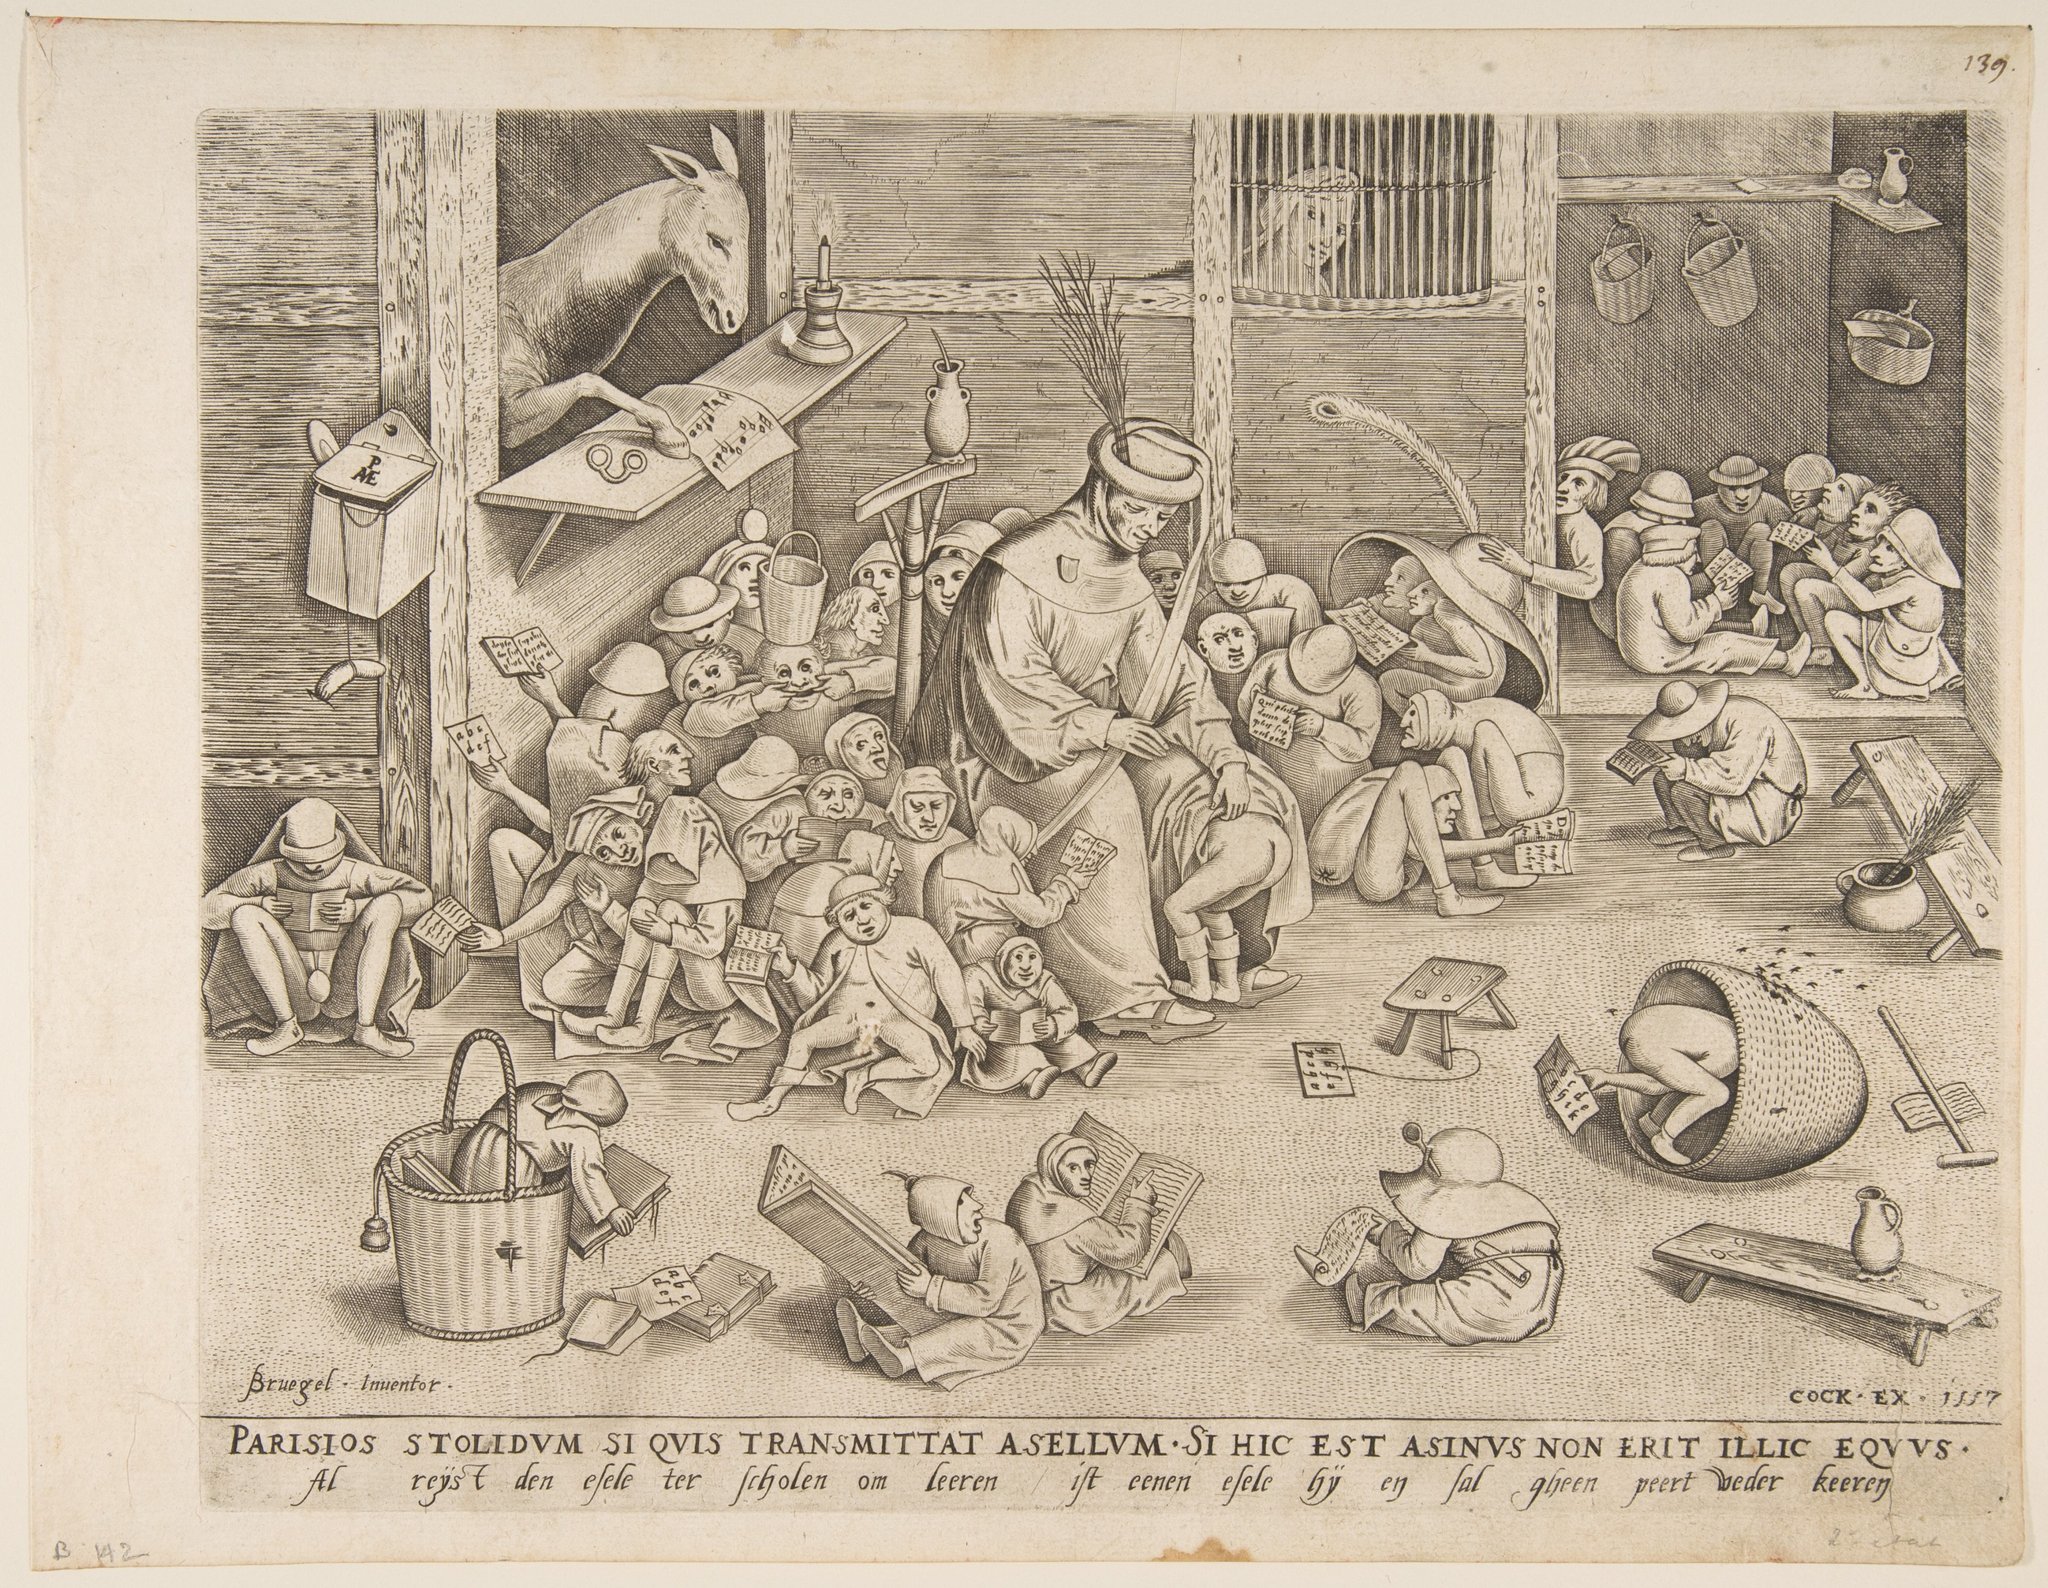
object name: print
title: The Ass at School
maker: pieter bruegel the elder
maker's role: artist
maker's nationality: netherlandish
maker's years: 1525-1569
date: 1557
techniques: engraving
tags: satire,schools,donkeys,students,teachers